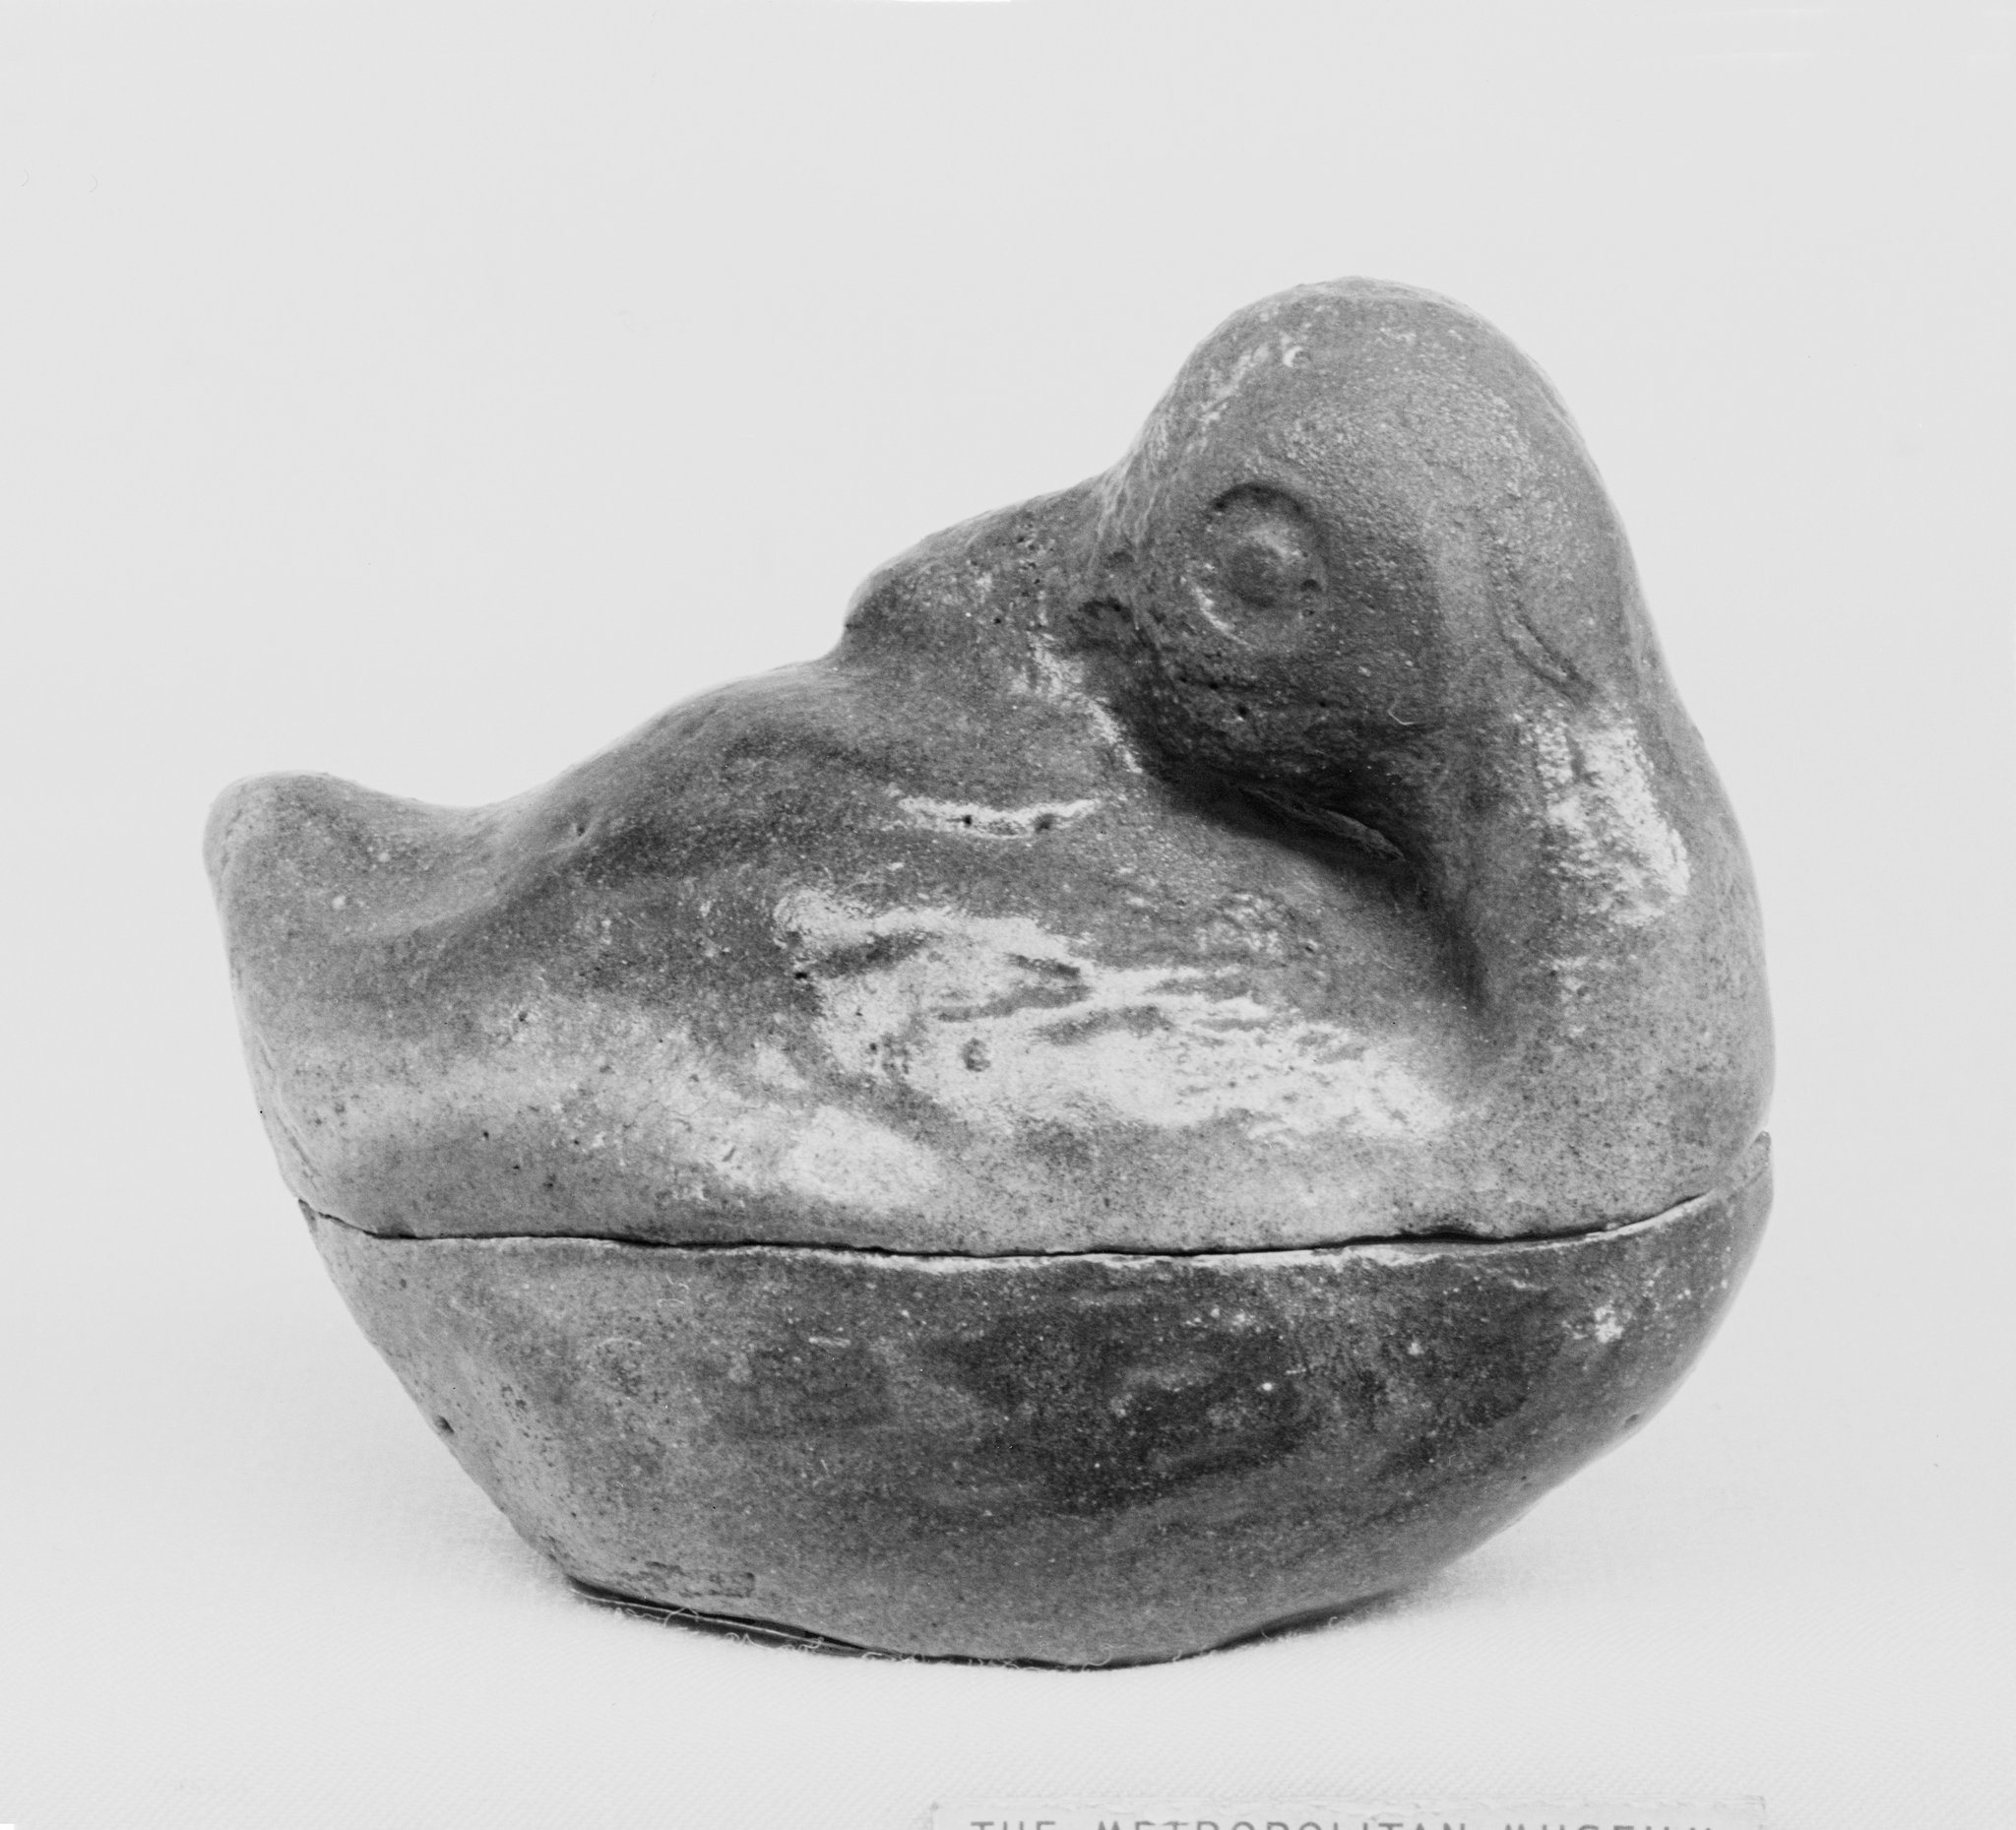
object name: incense box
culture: japanese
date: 1801-1900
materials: clay, glaze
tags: ducks